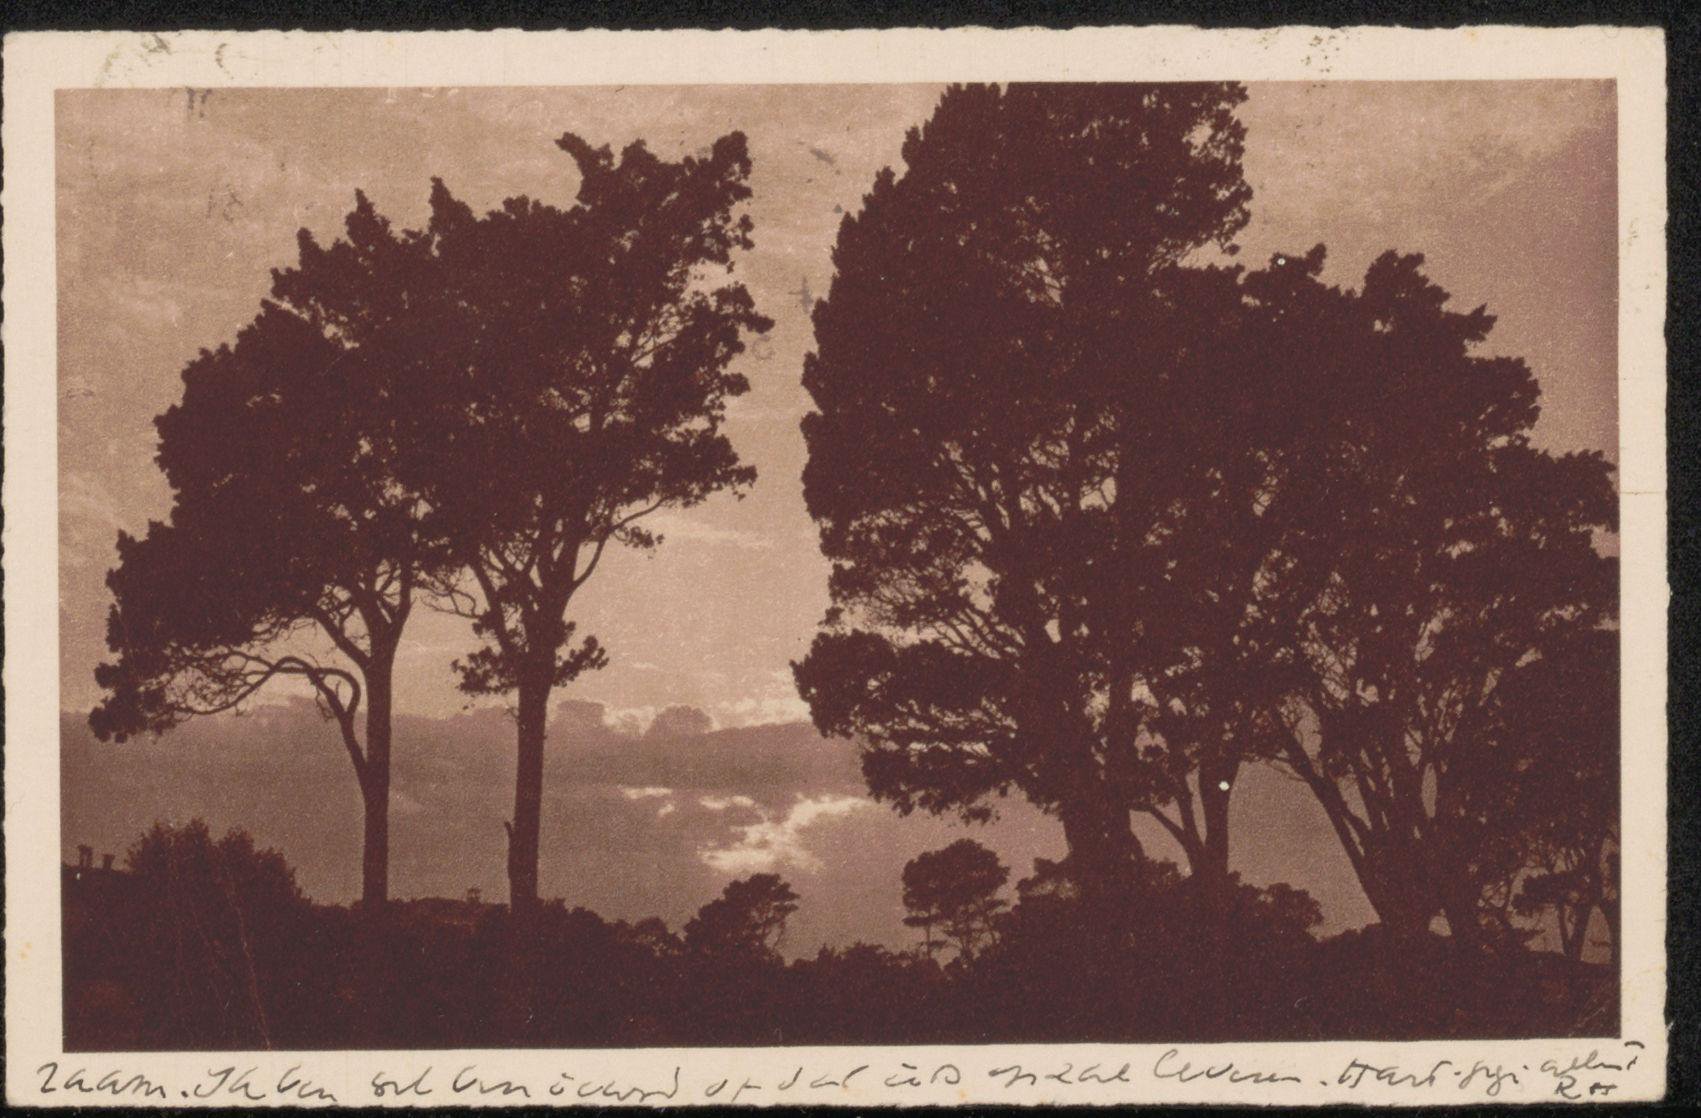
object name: ansichtkaart, prentbriefkaart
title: Prentbriefkaart aan Willem Bogtman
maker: richard nicolaüs roland holst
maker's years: 1868-1938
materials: cardboard, ink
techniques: photograph, pen, writing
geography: mulhouse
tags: haarlem, willem bogtman, applied arts, arts and crafts; industrial design, photography, cinematography